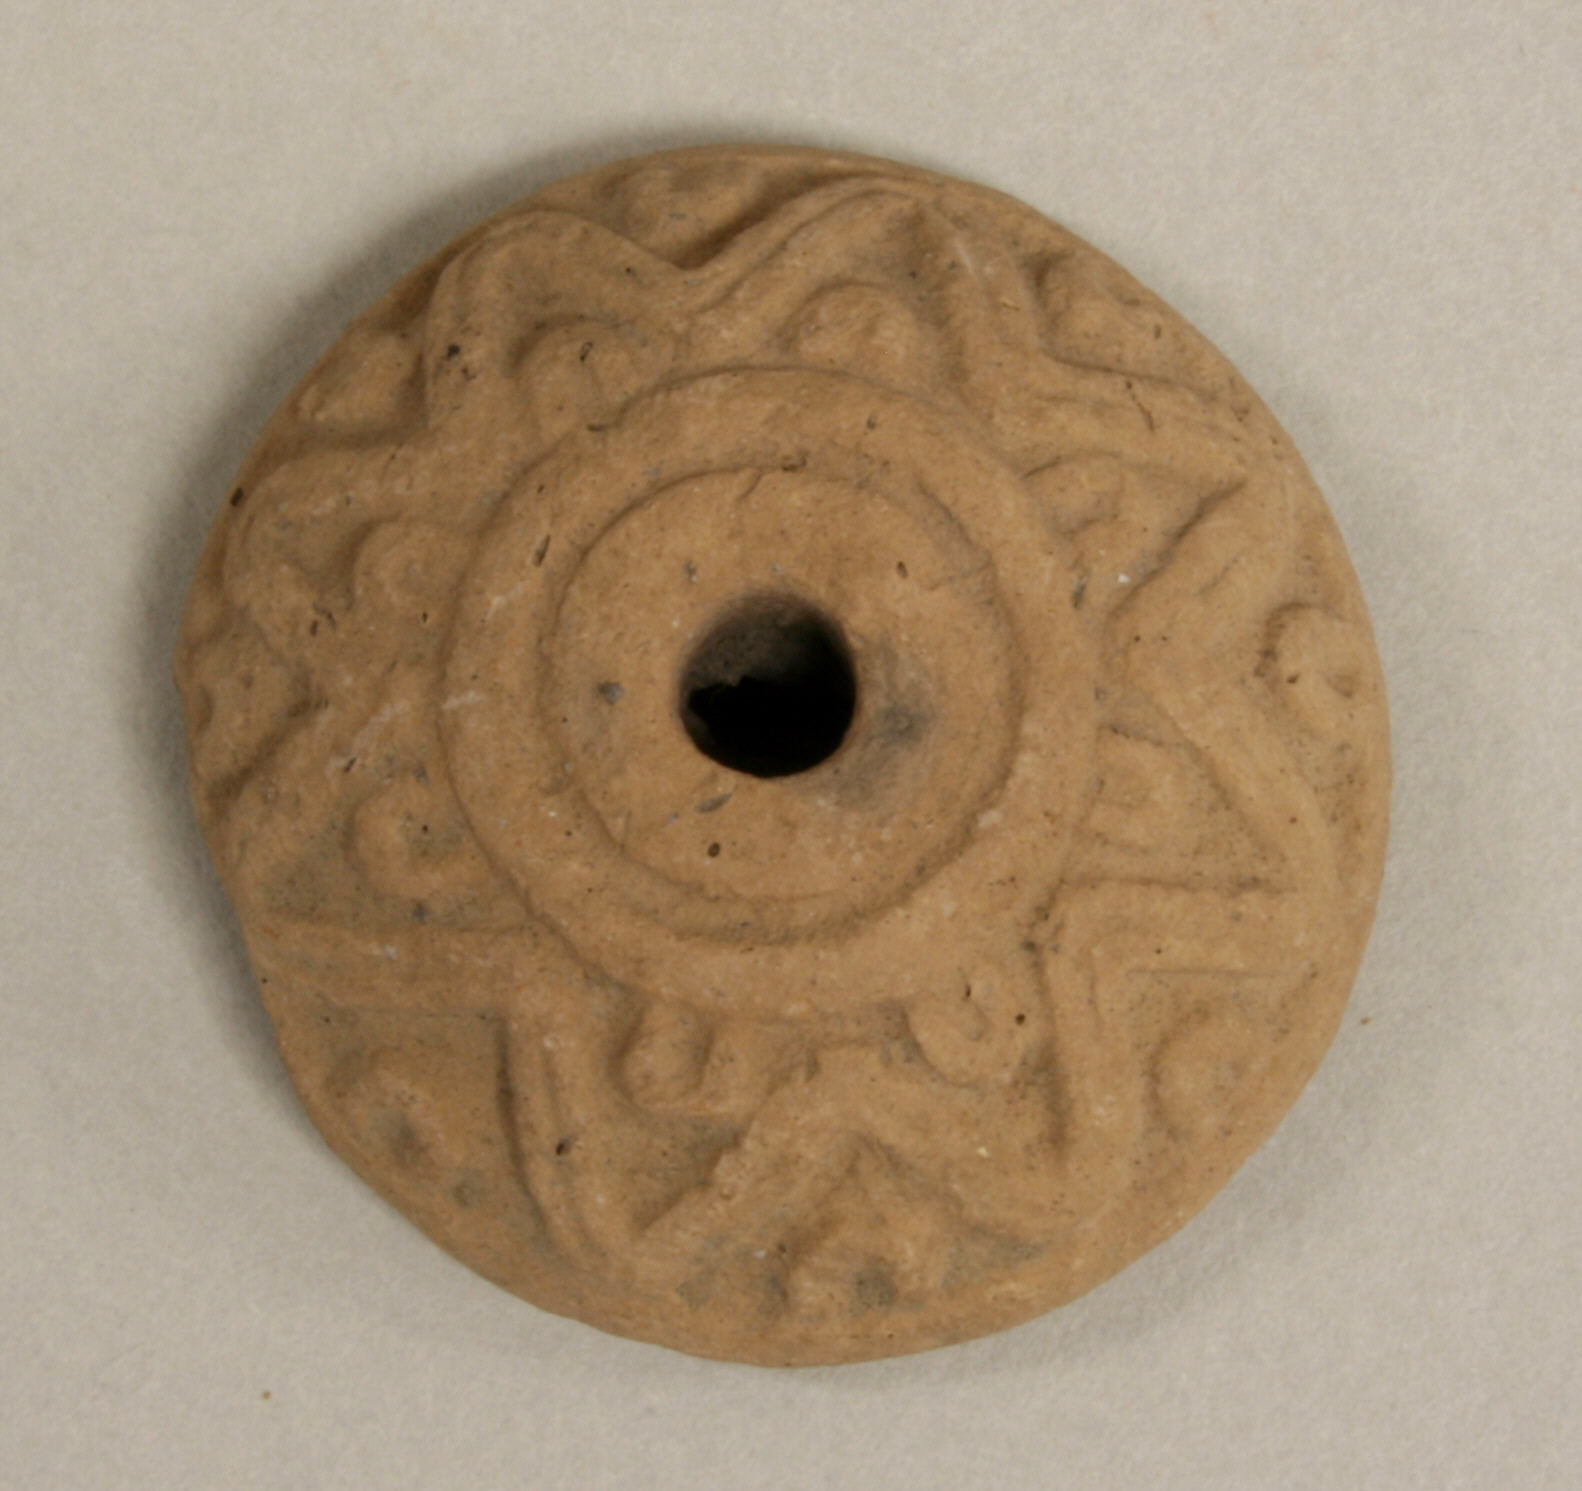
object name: spindle whorl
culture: mexican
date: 801-1500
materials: ceramic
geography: mexico